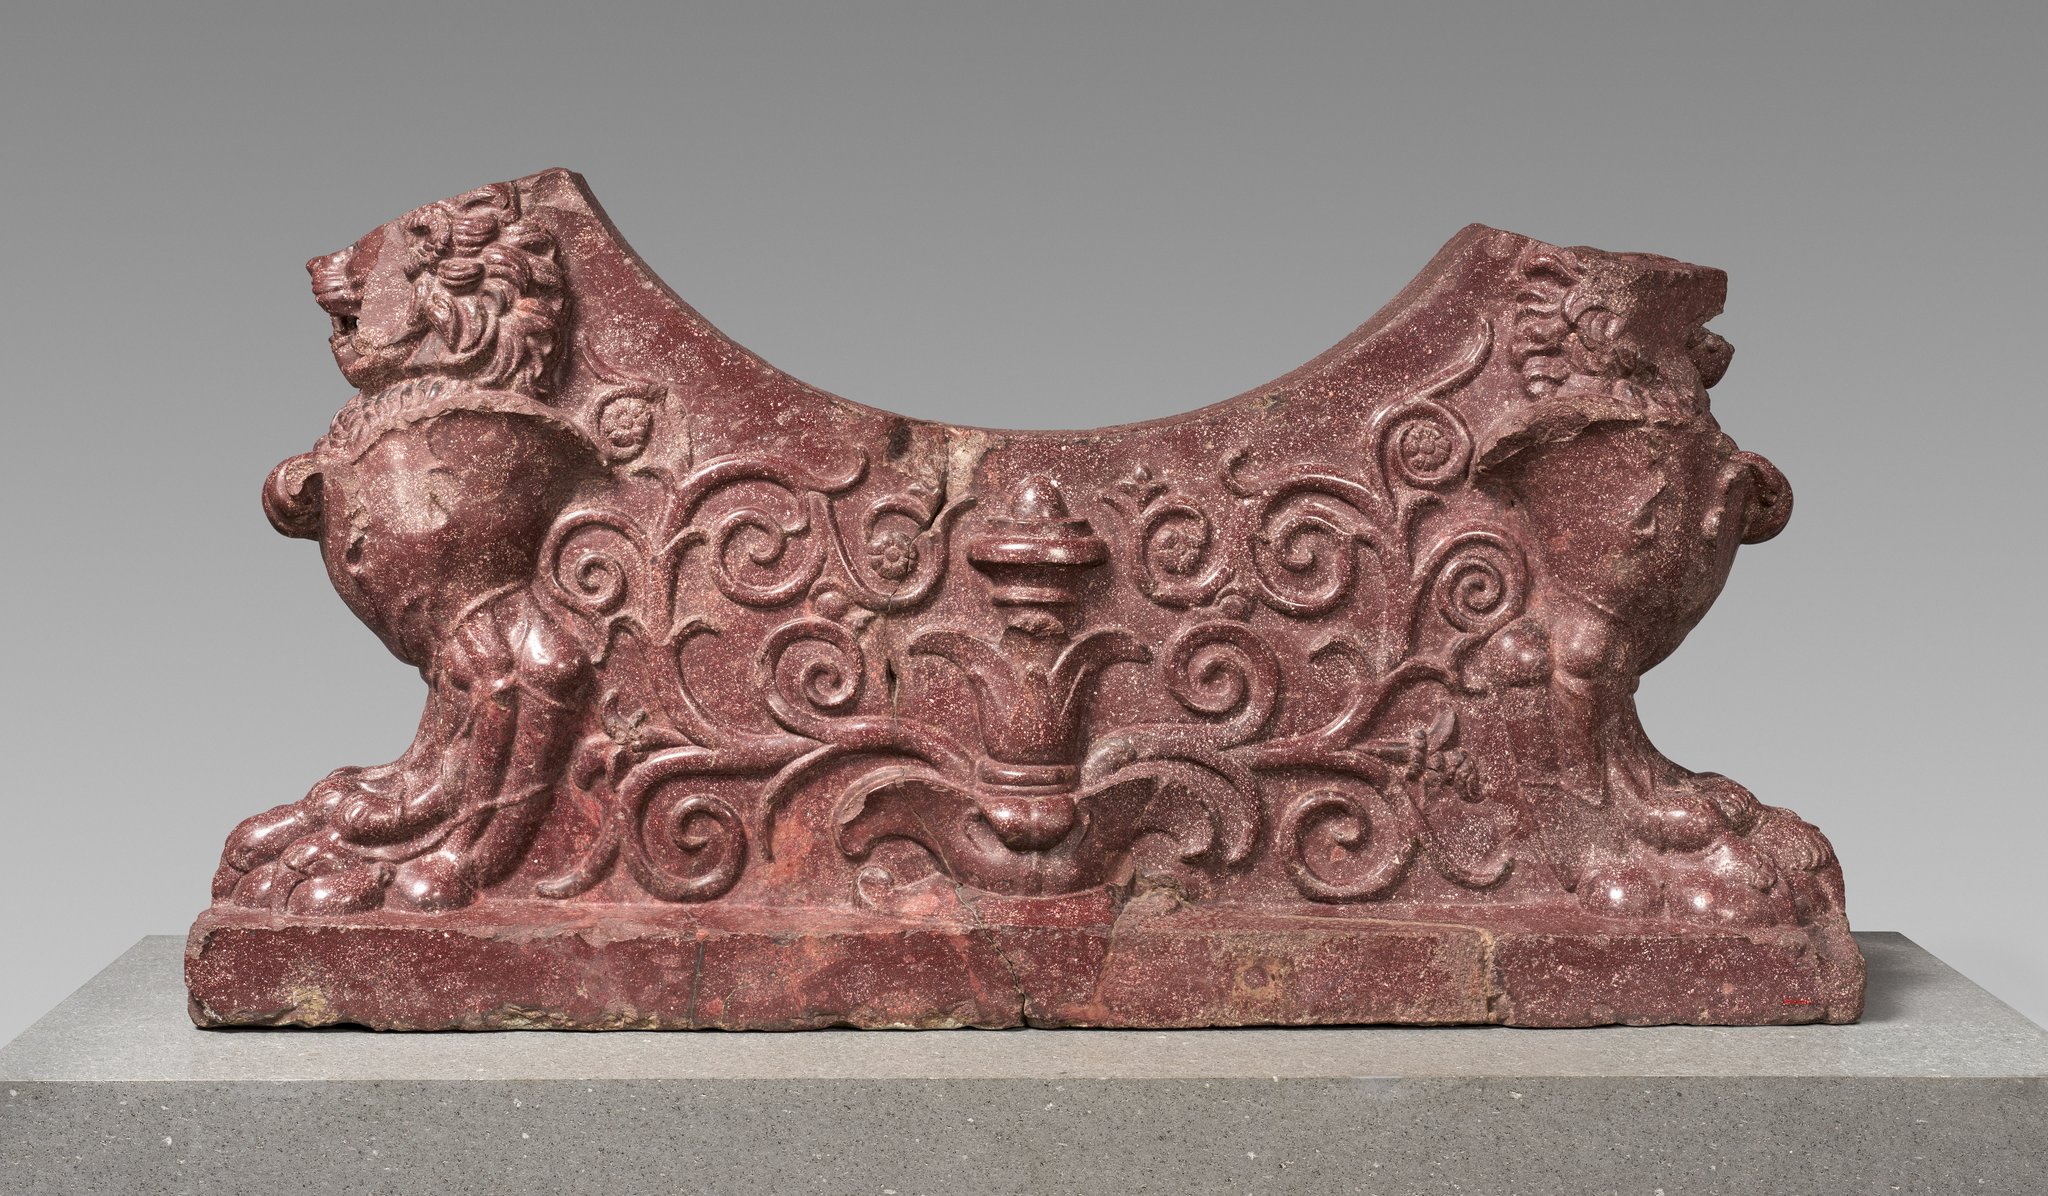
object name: stand for a basin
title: Porphyry support for a water basin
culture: roman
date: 101-200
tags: lions